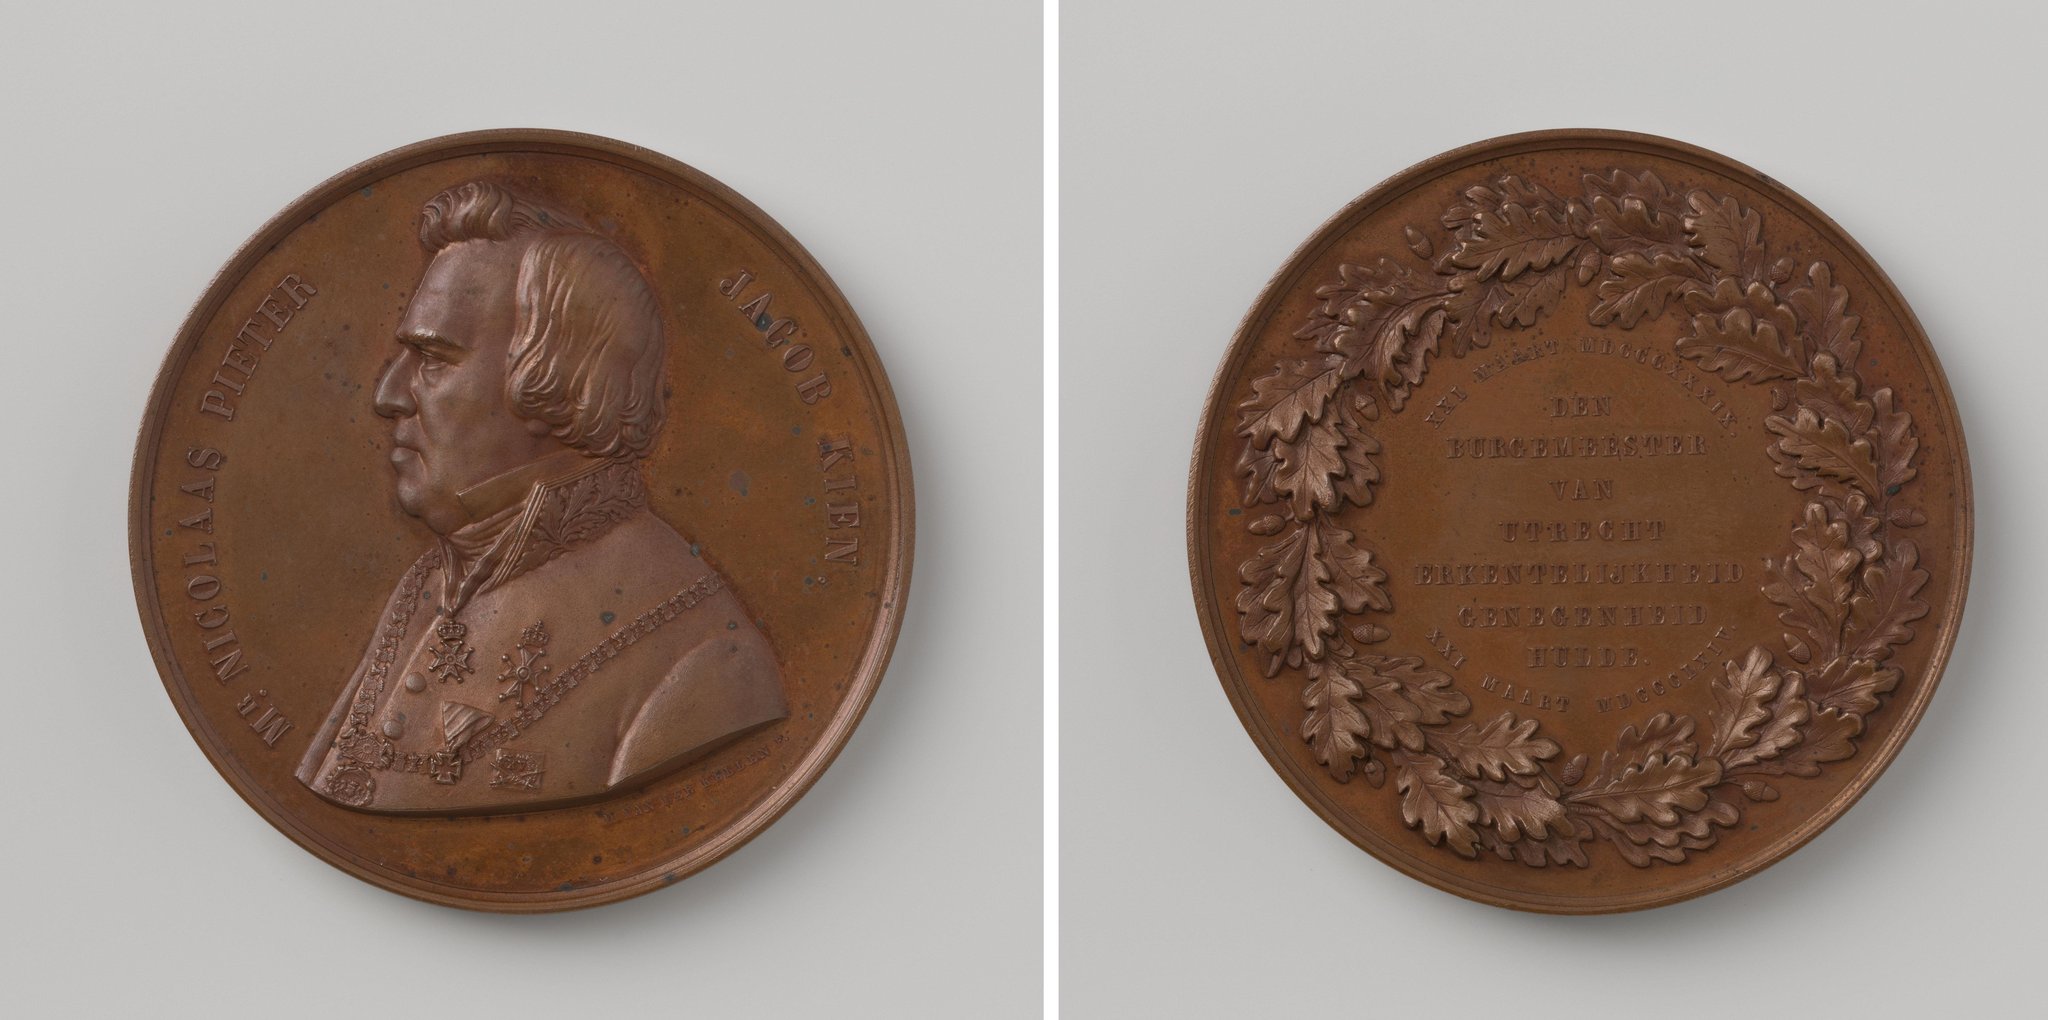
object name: honorary medal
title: Nicolaas Pieter Jacob Kien, vijfentwintig jaar burgemeester van Utrecht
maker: david van der kellen (1804-1879)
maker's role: die cutter, draughtsman, print maker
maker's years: 1804-1879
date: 1864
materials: bronze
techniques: striking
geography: utrecht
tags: mayor, utrecht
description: Bronzen penning. Voorzijde: borststuk man binnen omschrift. Keerzijde: opschrift binnen omschrift en eikekrans